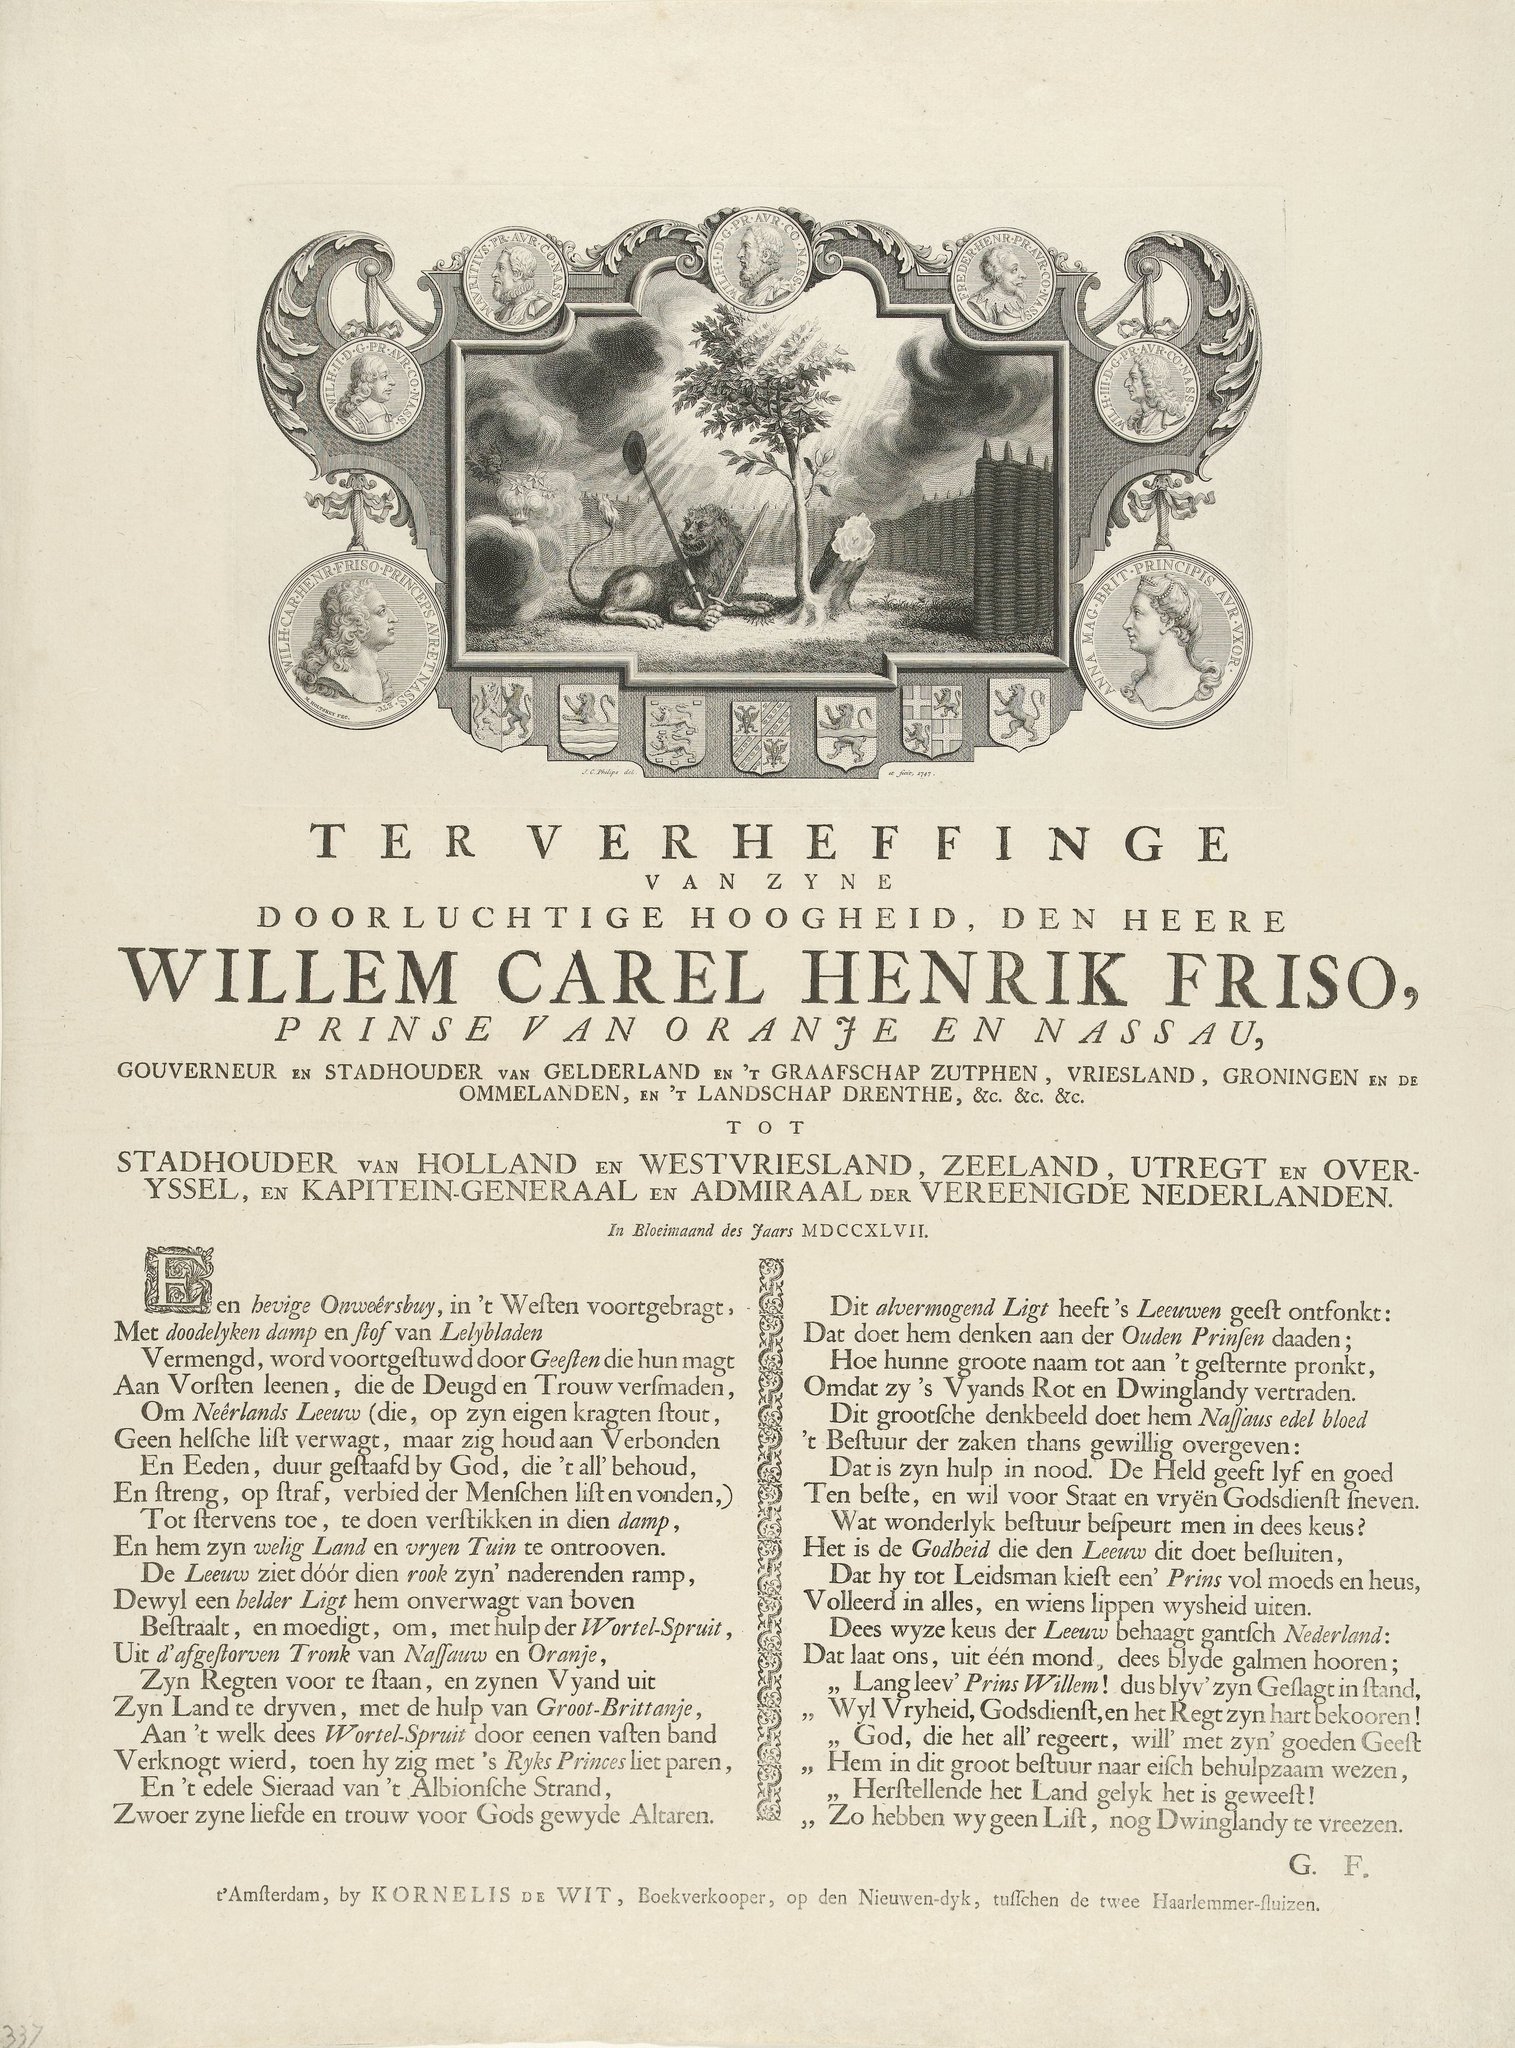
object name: print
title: Ter Verheffinge van zyne doorluchtige hoogheid, den heere Willem Carel Henrik Friso (...) tot Stadhouder van Holland en Westvriesland, Zeeland, Utregt en Overyssel, en Kapitein-Generaal en Admiraal der Vereenigde Nederlanden. In Bloeimaand des Jaars MDCCXLVII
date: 1747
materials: paper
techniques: engraving, etching, letterpress printing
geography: northern netherlands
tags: carolina (prinses van oranje-nassau), willem iv (prins van oranje-nassau), anna van hannover, fenced or walled garden; 'hortus conclusus'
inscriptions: collector's mark: Lugt 2228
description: Allegorie op de verheffing van prins Willem IV tot stadhouder in mei 1747. De Nederlandse Leeuw met zwaard, lans en vrijheidshoed wakend in de Hollandse Tuin bij de door het goddelijke licht beschenen Oranjeboom. In omlijsting met wapens van de zeven provincies en portretmedaillons van prins Willem IV en zijn vrouw Anna van Hannover en de eerdere prinsen van Oranje. Op het blad onder de plaat een vers in twee kolommen gesigneerd G.F.